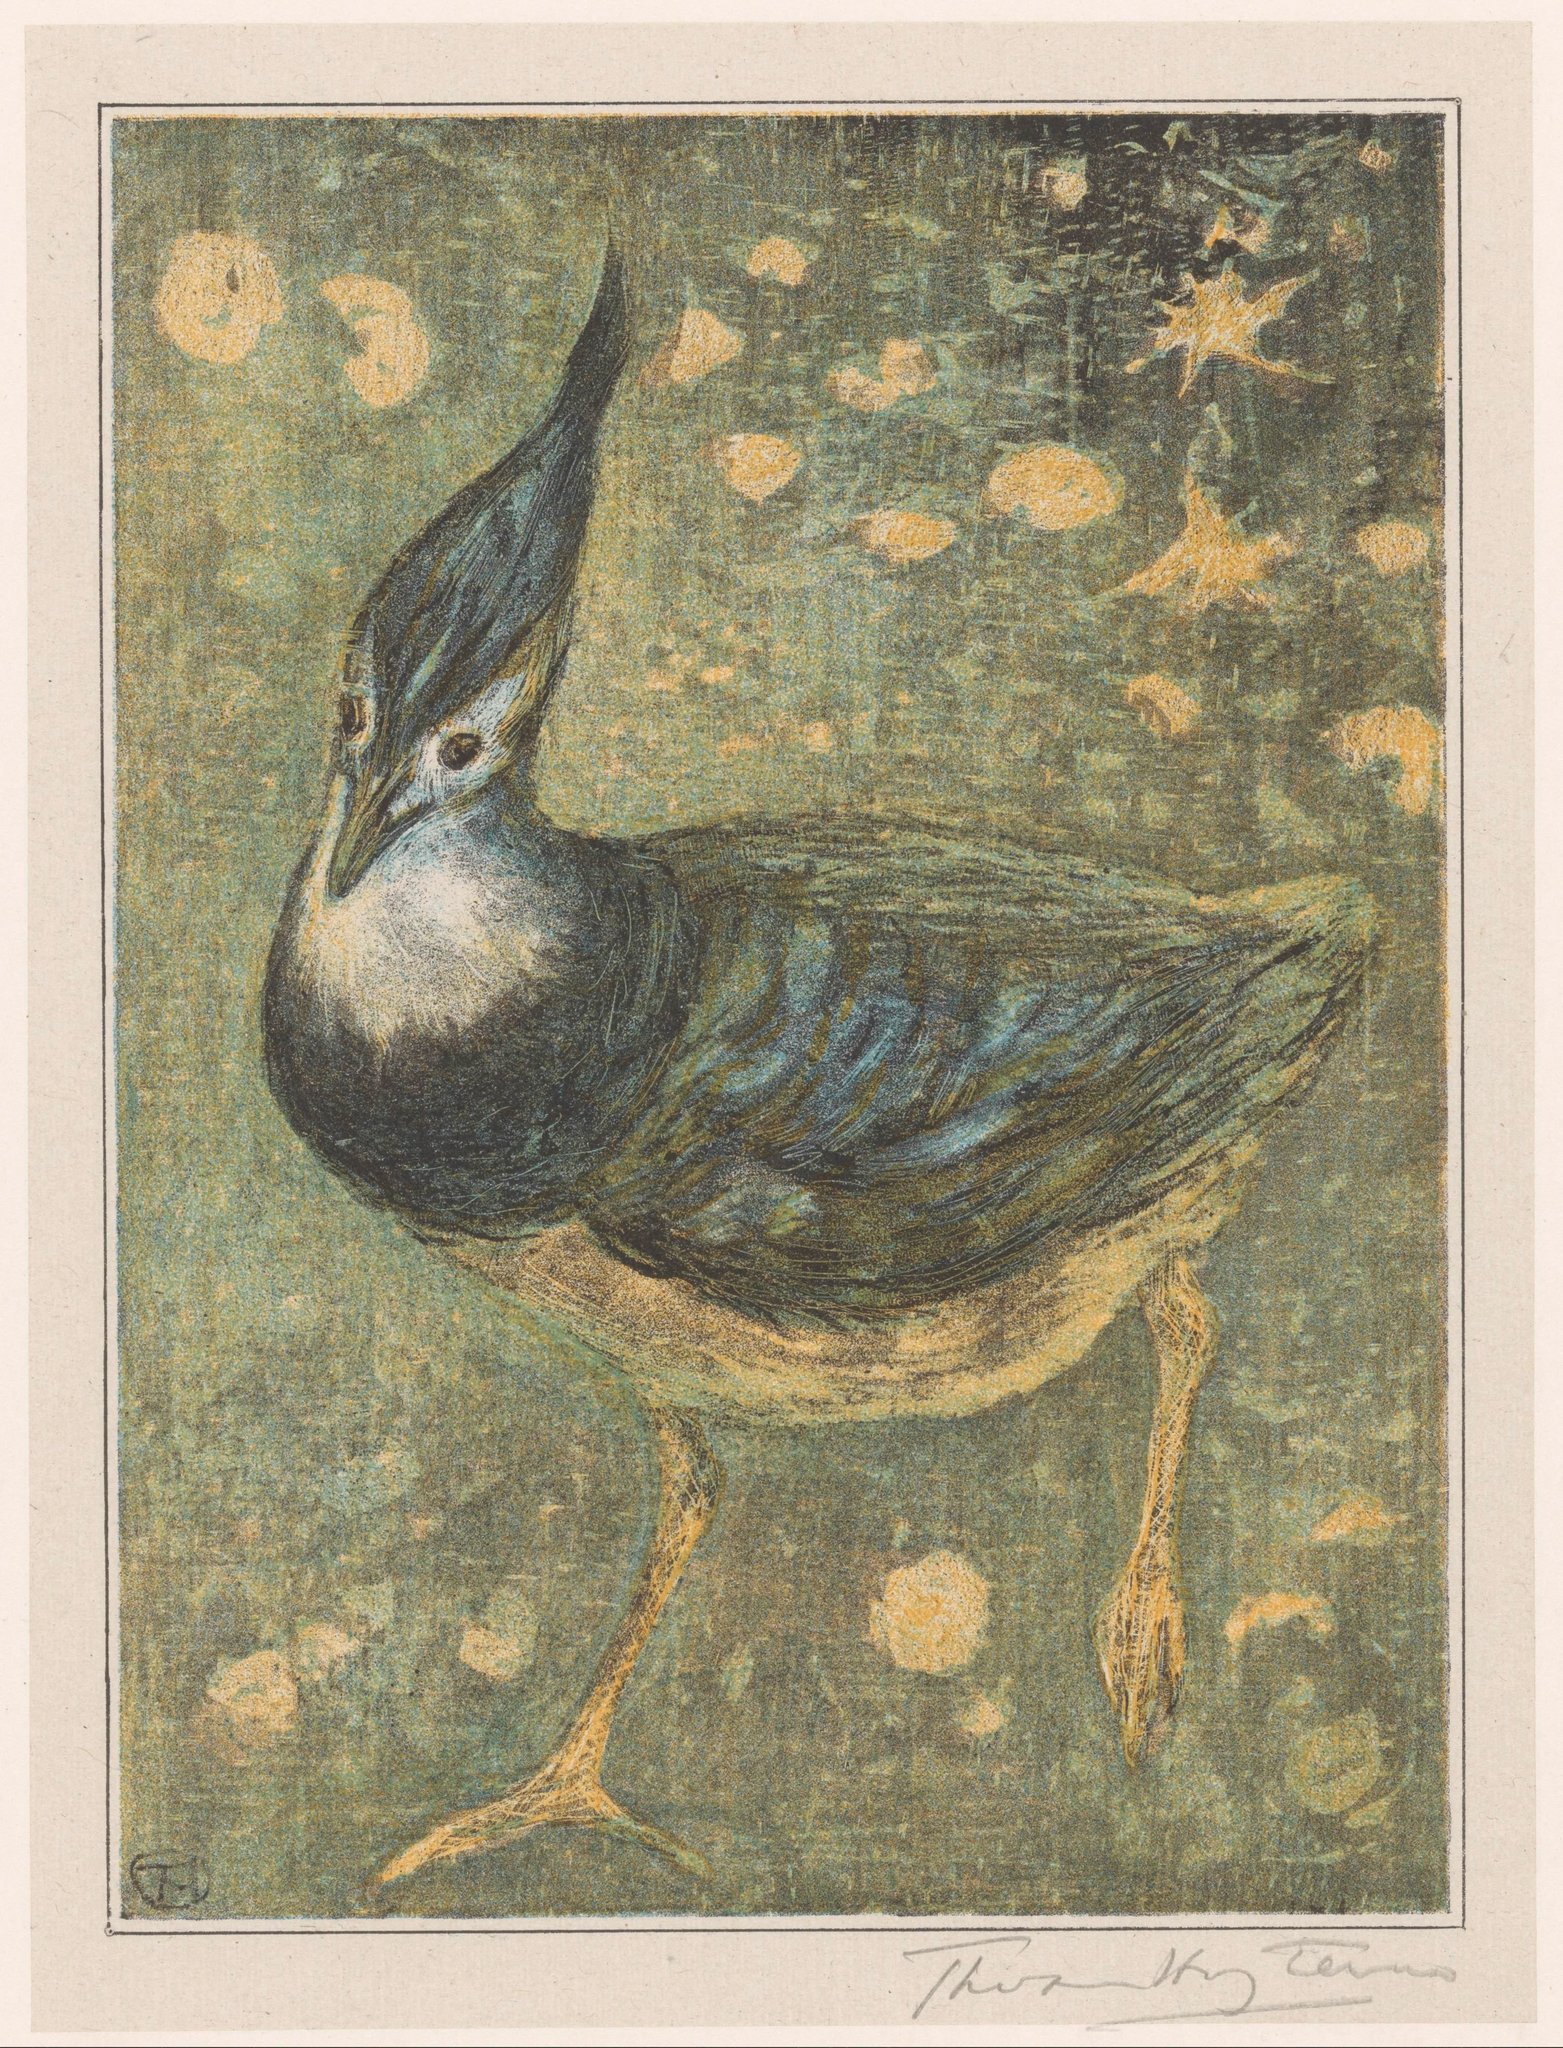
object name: print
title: Kievit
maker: theo van hoytema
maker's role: draughtsman, painter, print maker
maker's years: 1863-1917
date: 1878-1908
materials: paper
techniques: lithograph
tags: shore-birds and wading-birds: lapwing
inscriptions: collector's mark: Lugt 2233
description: Prent is een proefdruk voor kalenderblad mei 1908.